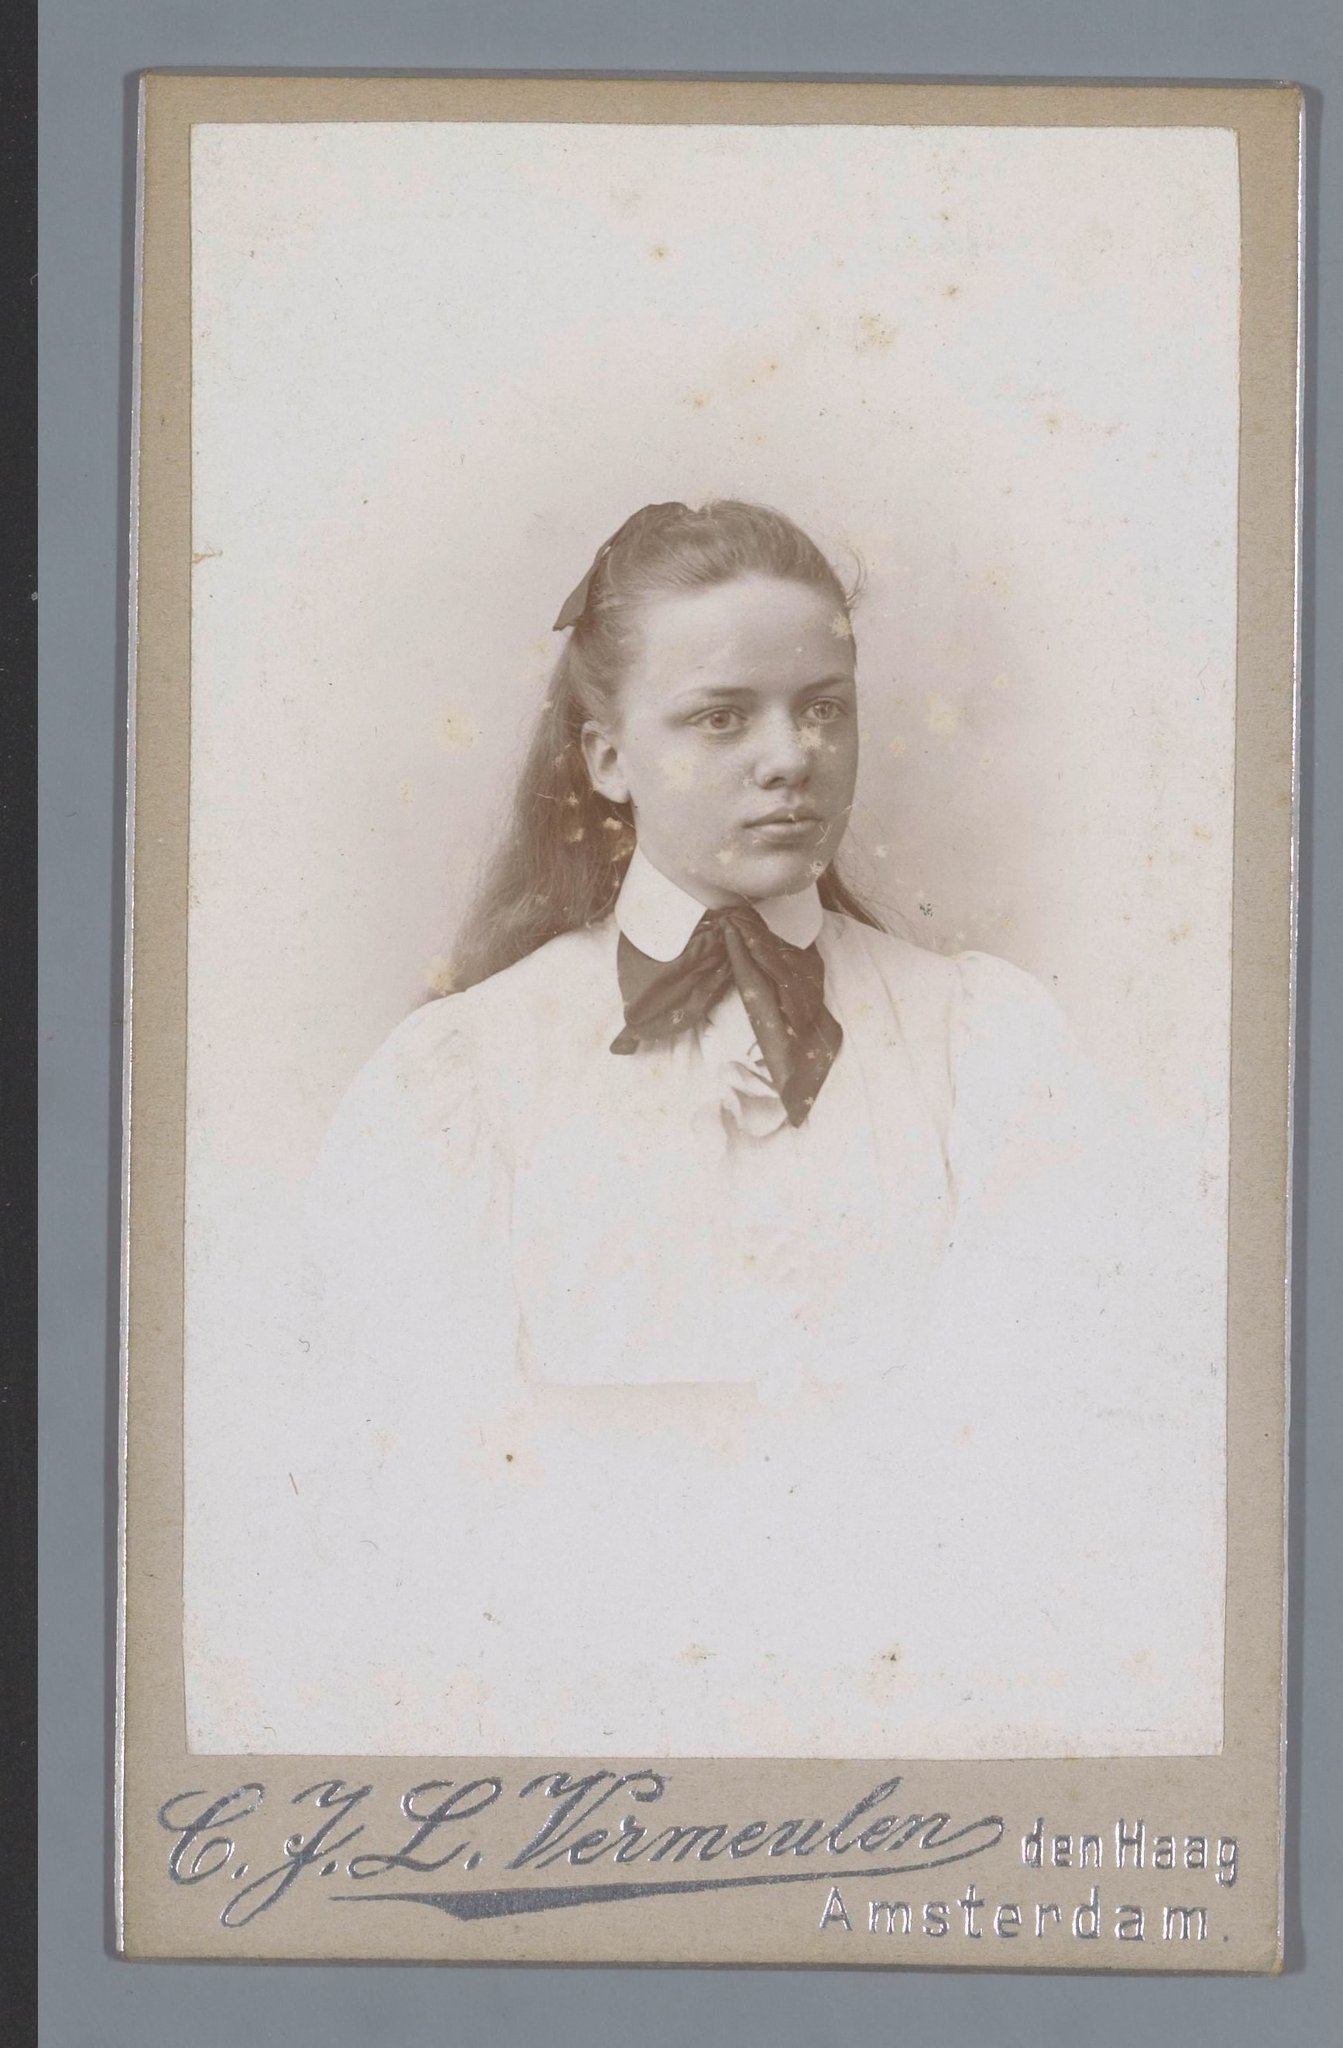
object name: photograph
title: Portret van een onbekende vrouw of meisje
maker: cornelis johannes lodewicus vermeulen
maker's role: fotograaf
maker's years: 1861-1936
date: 1888-1915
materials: cardboard, paper, photographic support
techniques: daylight paper print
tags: adult woman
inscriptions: inscription: ‘C.J.L. Vermeulen Heerenstraat 6, Heiligenweg hoek Singel Amsterdam Telephoon No. 2339 en 2340. Toussaintkade 11. den Haag. Intercommunal Telephoon: 774.’, name: ‘C.J.L. Vermeulen den Haag Amsterdam.’